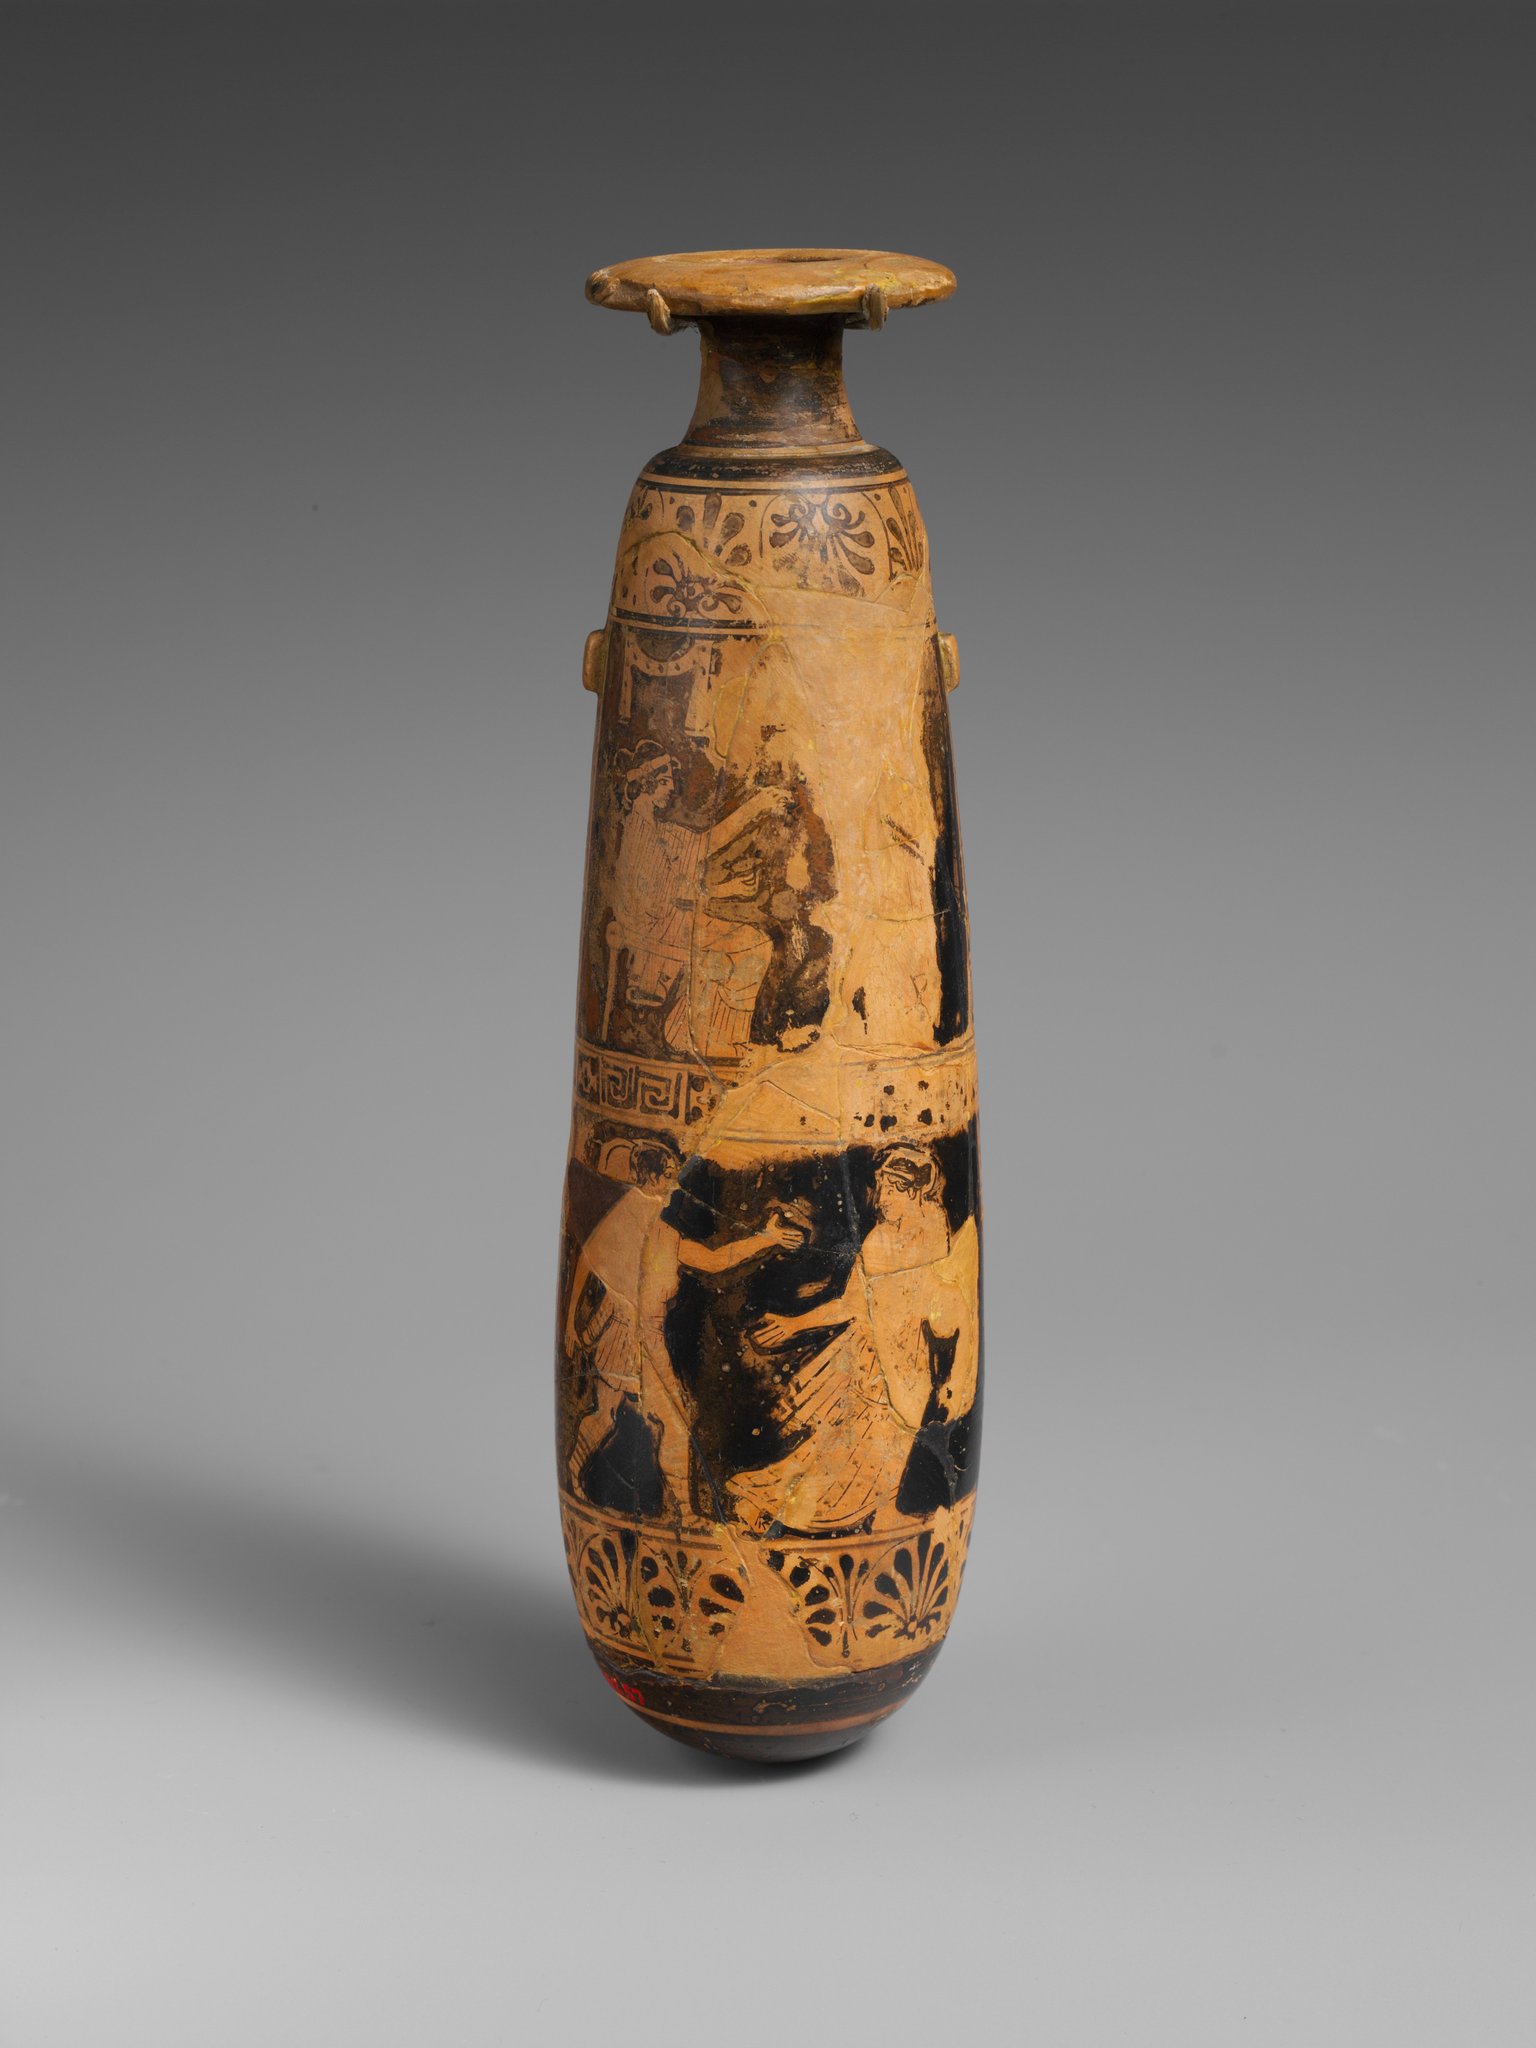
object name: alabastron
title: Terracotta alabastron (perfume vase)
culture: greek, attic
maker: beth pelet painter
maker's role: artist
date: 460 BCE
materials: terracotta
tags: men,women